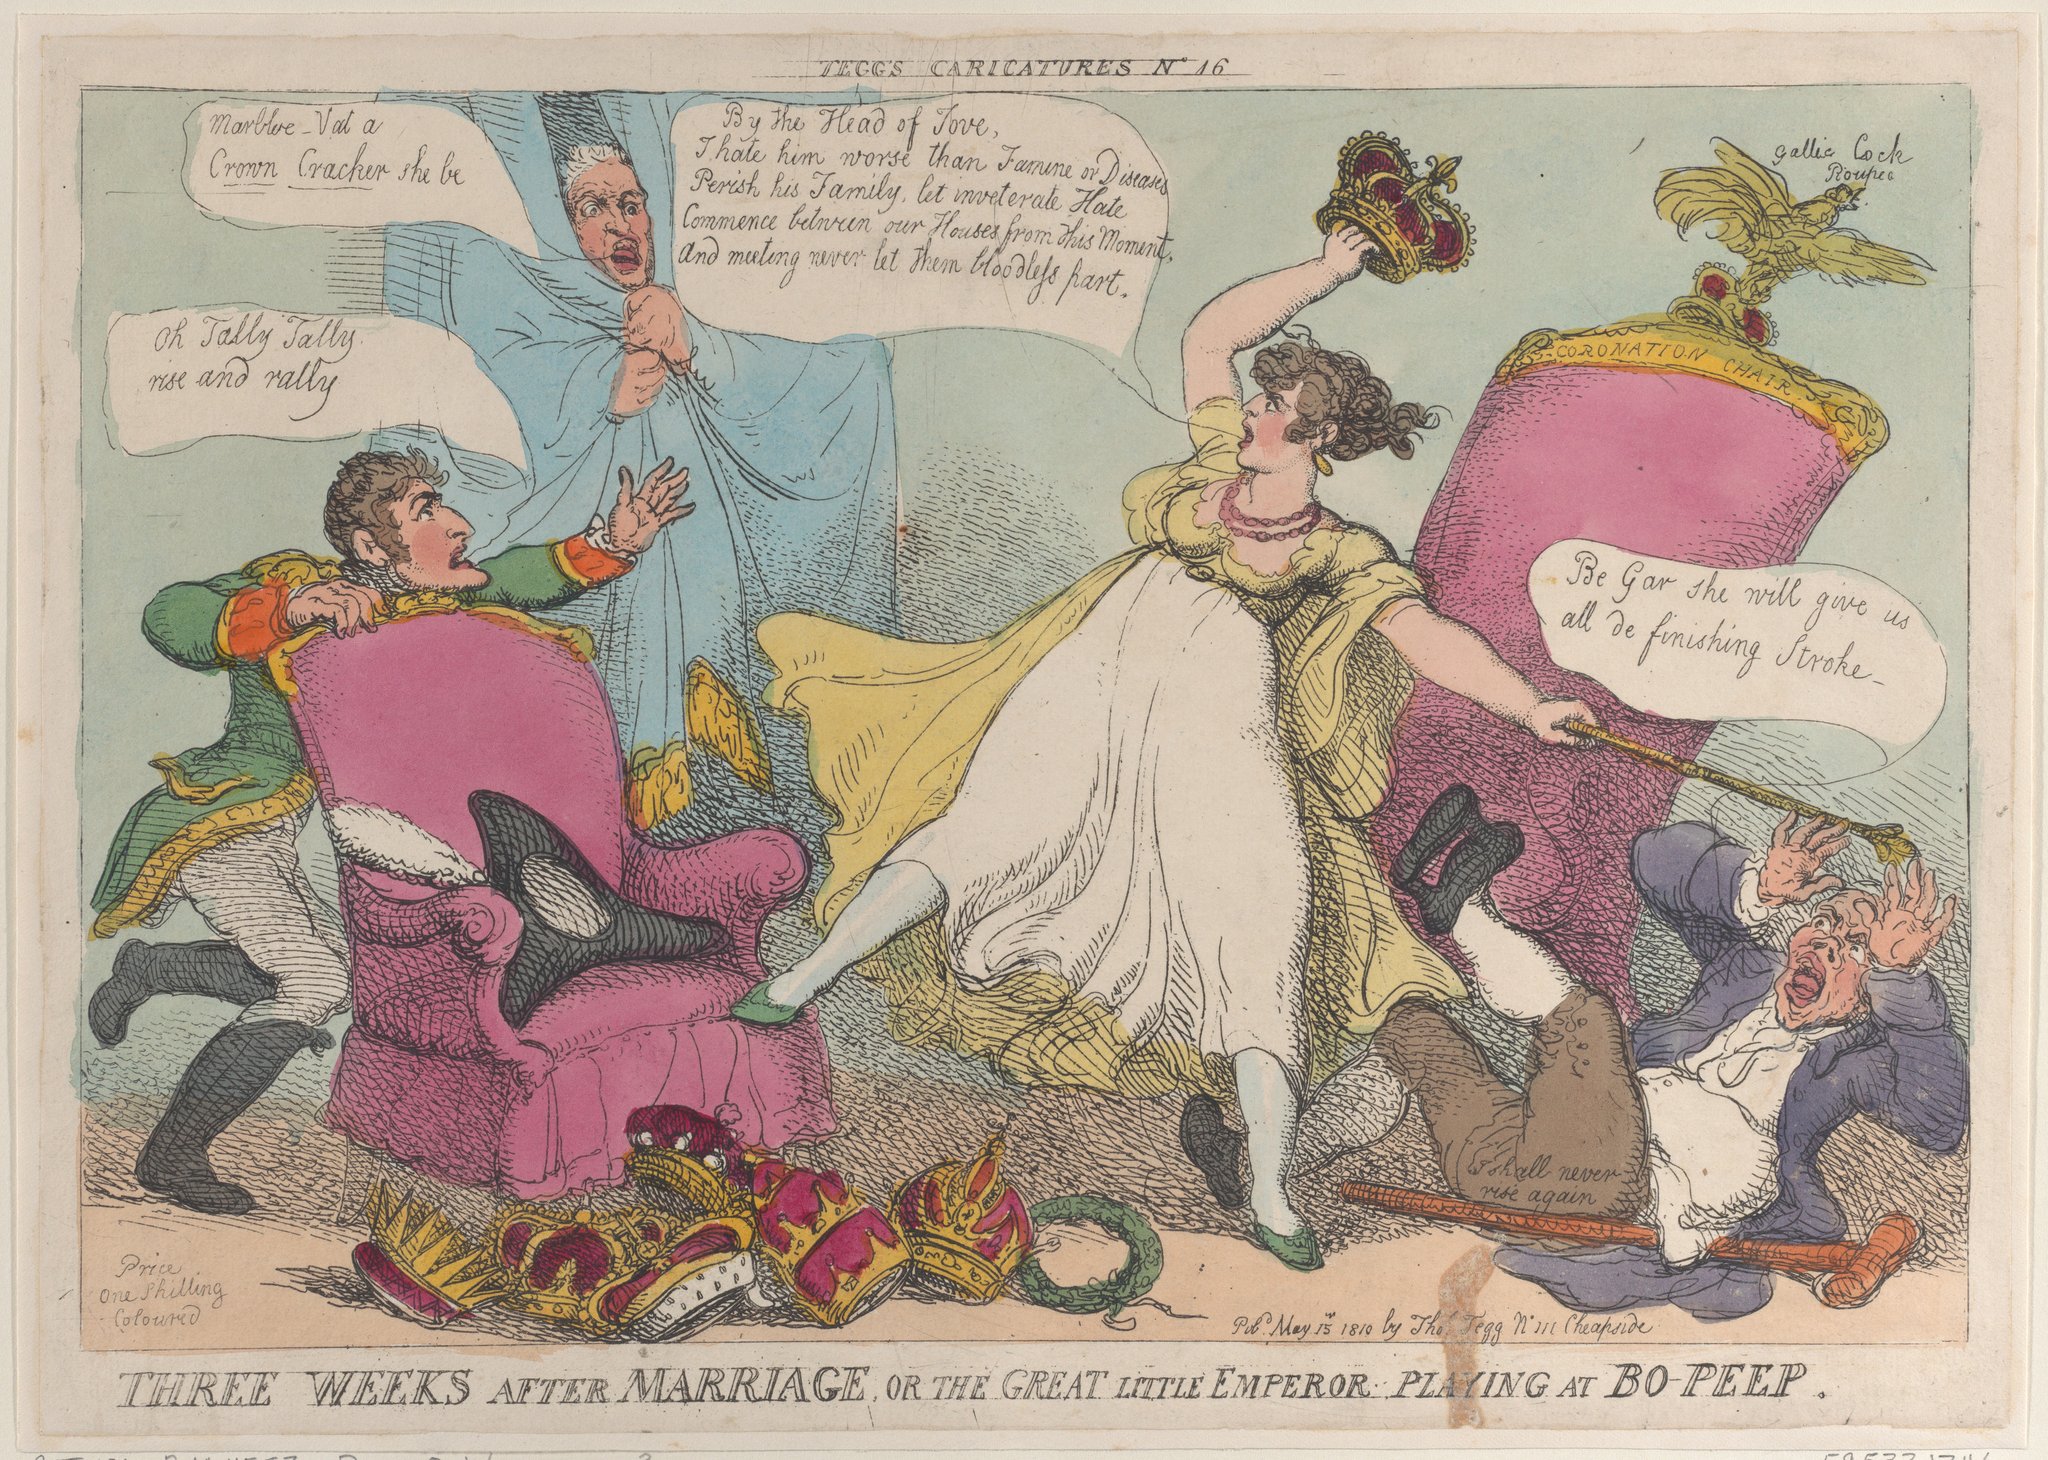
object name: print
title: Three Weeks After Marriage, or the Great Little Emperor Playing at Bo-Peep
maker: thomas rowlandson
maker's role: artist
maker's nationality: british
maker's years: 1757-1827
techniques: etching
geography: london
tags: satire,napoleon i,men,women,crowns